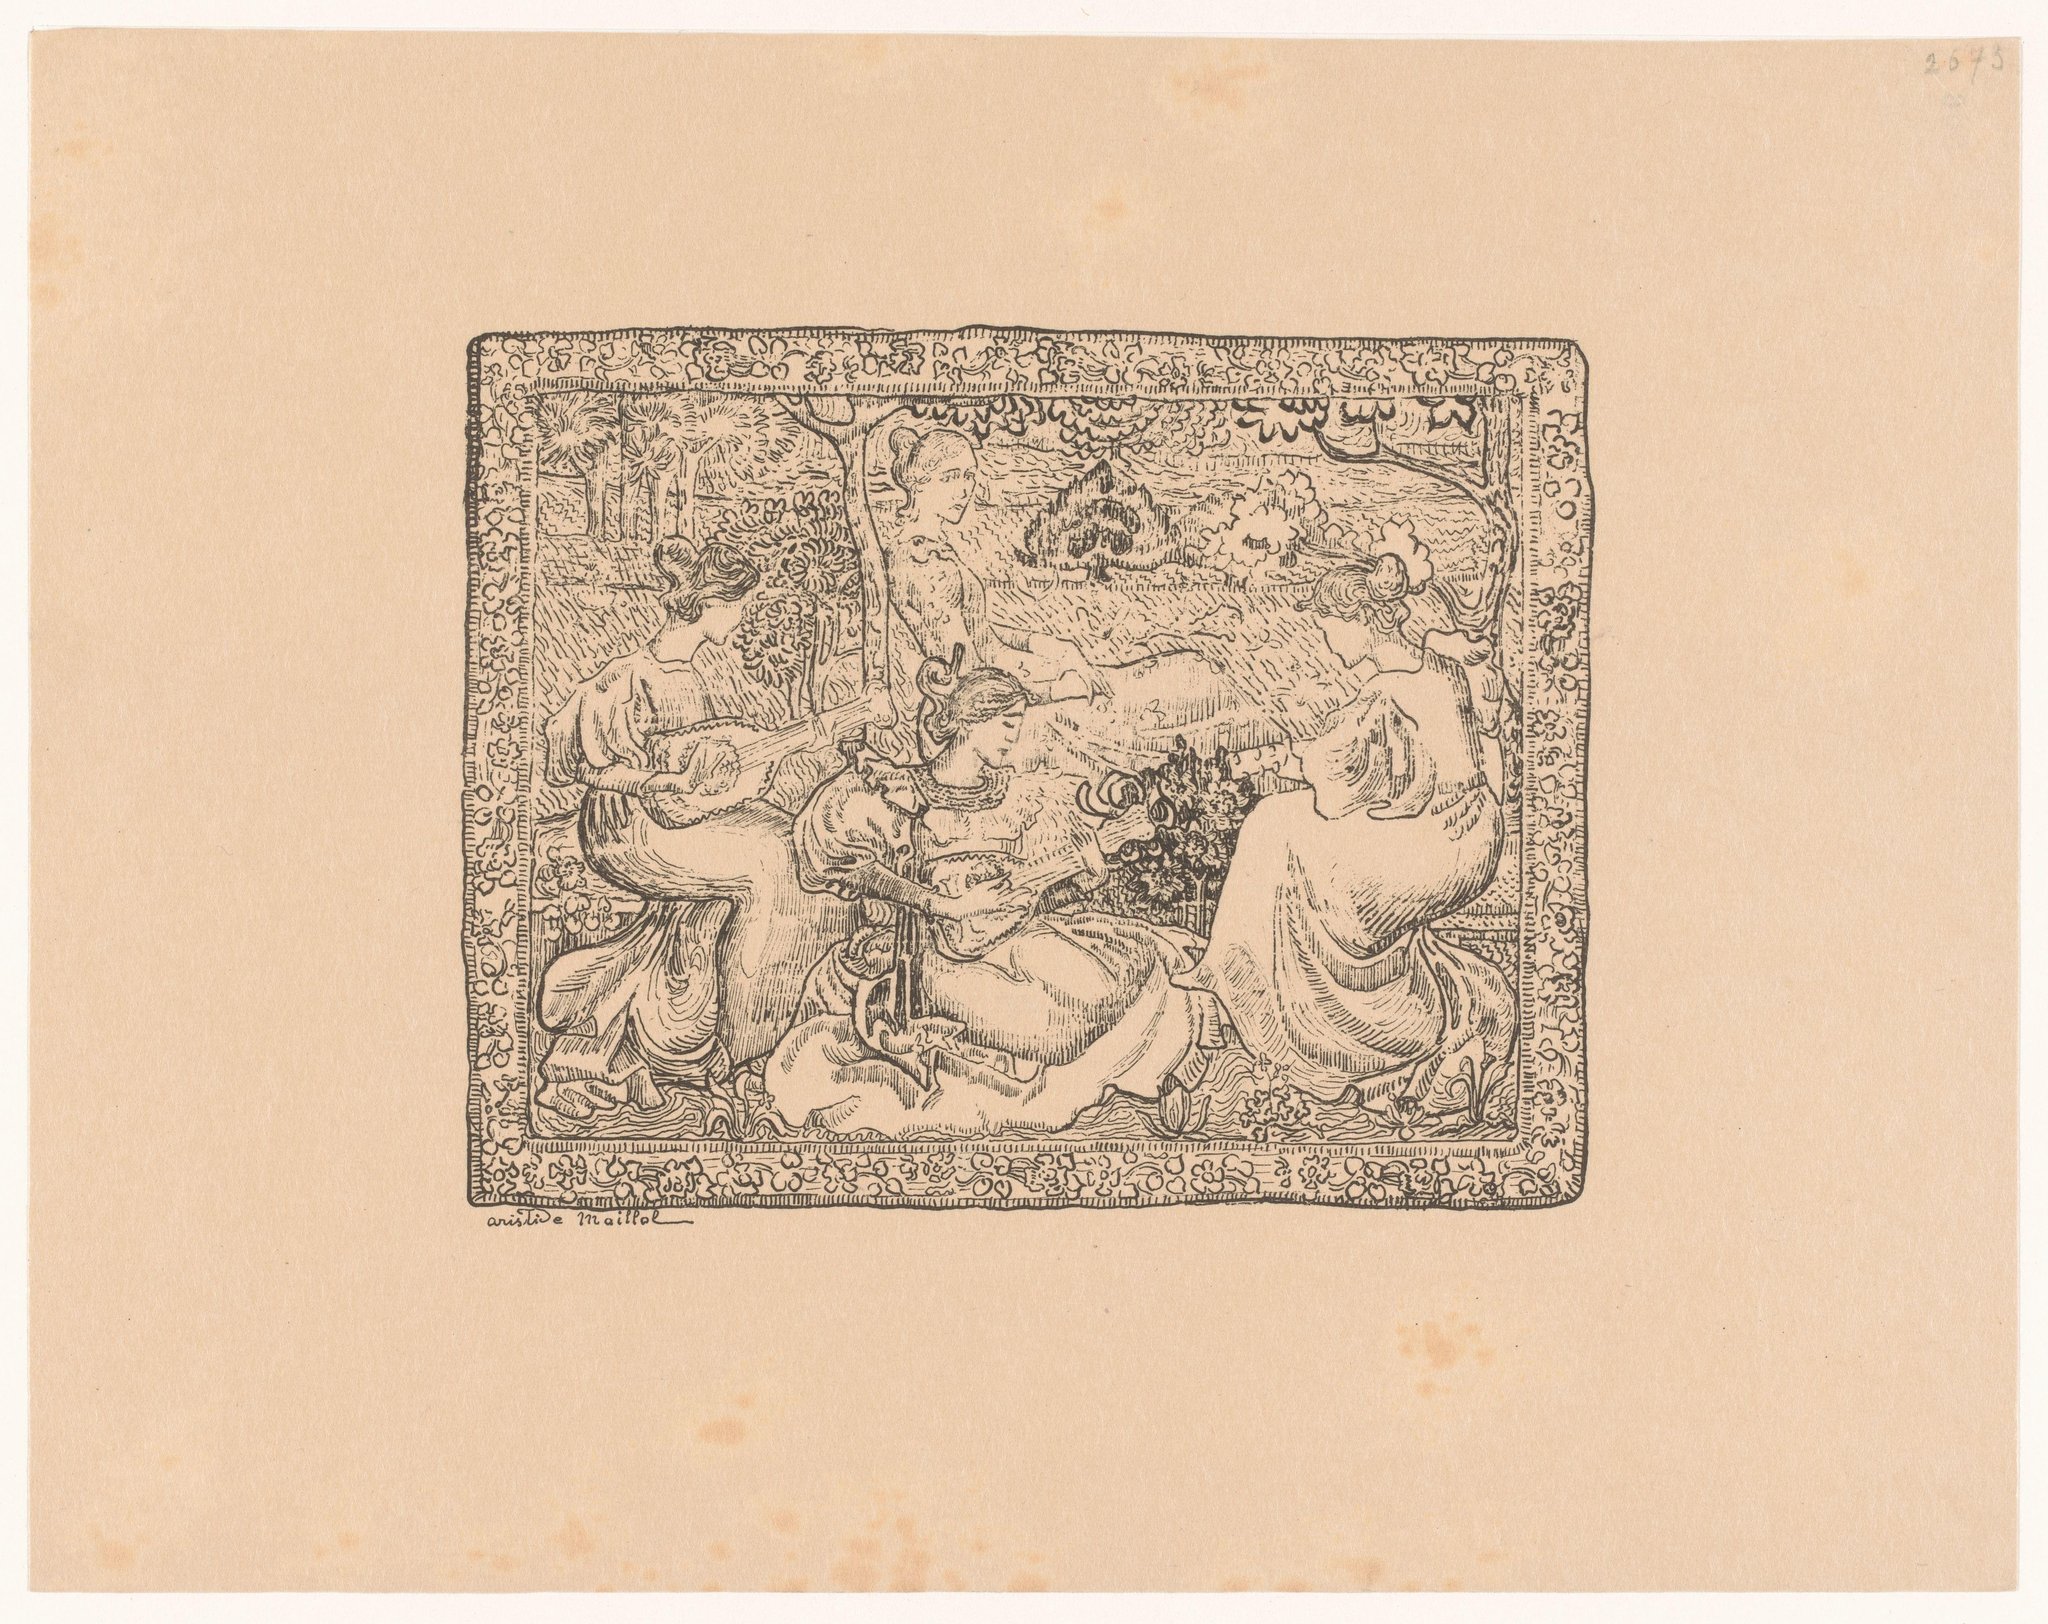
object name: print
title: Wandtapijt met vier musicerende vrouwen in landschap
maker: aristide maillol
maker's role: draughtsman, painter, print maker, sculptor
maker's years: 1861-1944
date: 1895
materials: paper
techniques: lithography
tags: cithern, mandolin, guitar, balalaika - cc - out of doors, tapestry, more than one musician with instrument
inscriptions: collector's mark: Lugt 2228, collector's mark: Lugt 2760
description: Prent ook verschenen in: L'Epreuve, 1895.